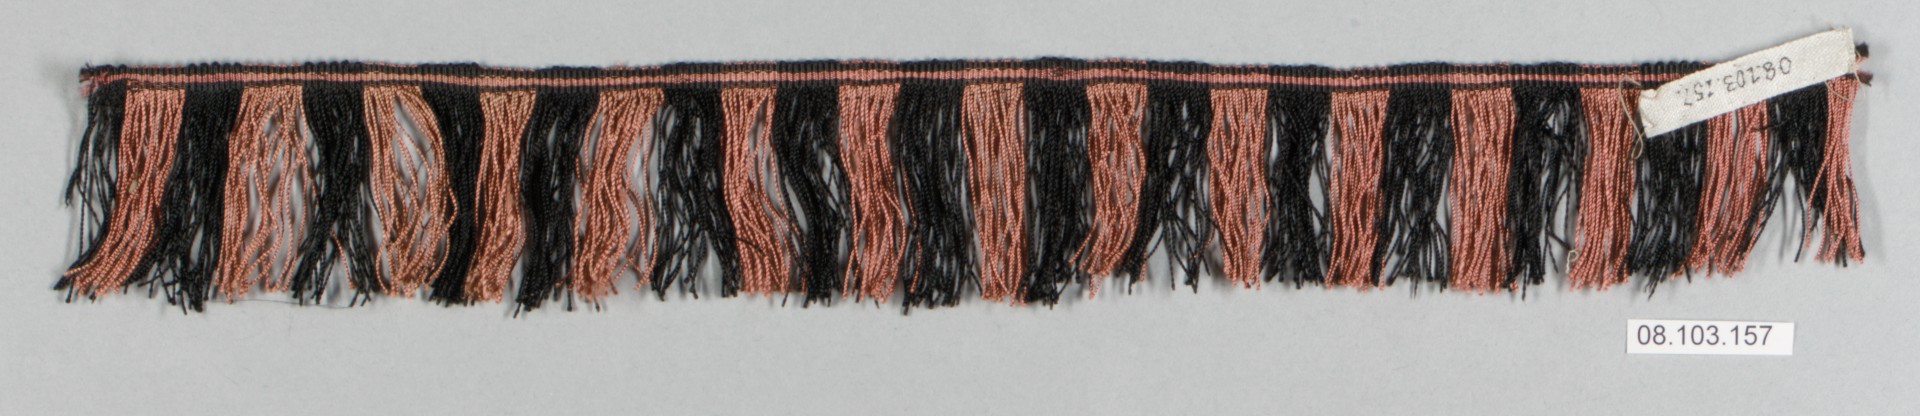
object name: fringe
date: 1801-1900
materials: silk